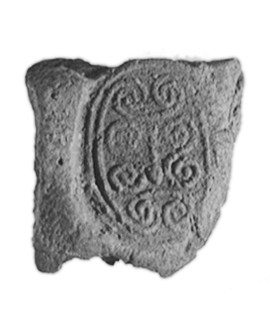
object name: sealing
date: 2030-1640 BCE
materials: clay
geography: egypt